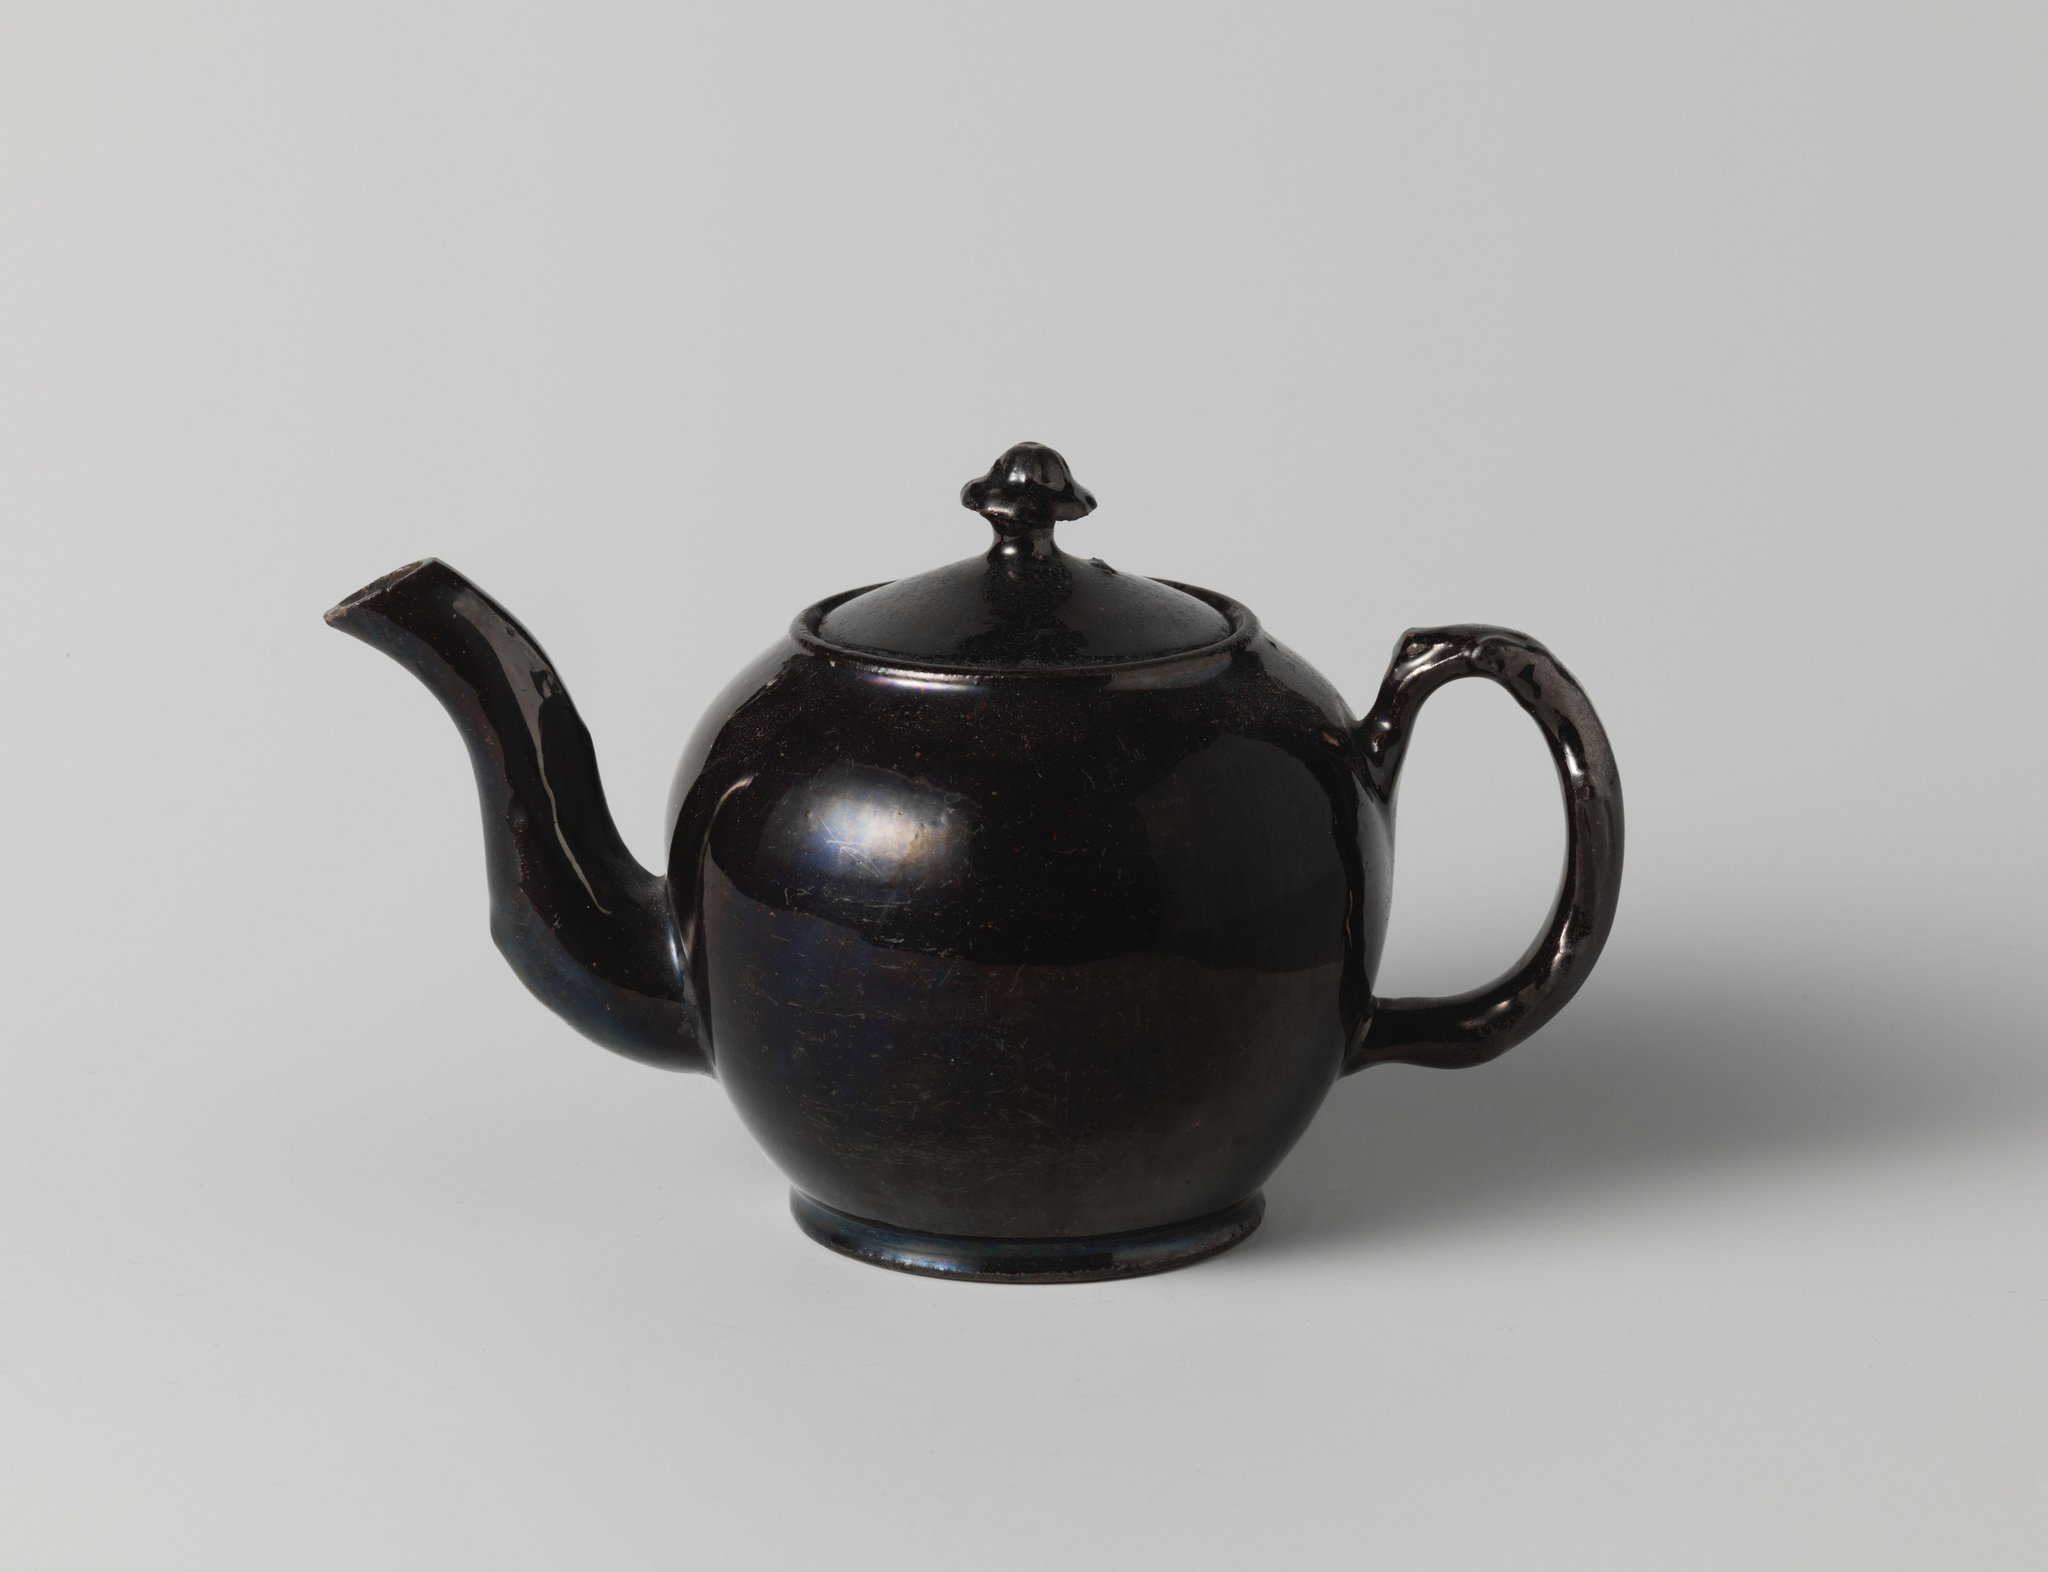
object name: teapot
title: Theepot met deksel van aardewerk met zwartdekkende glazuur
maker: Anonymous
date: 1740-1770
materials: earthenware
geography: jackfield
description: Bolvormige theepot met deksel van aardewerk met zwartdekkende glazuur. De pot heeft een C-vormig oor, een deksel met een knop en een S-vormige tuit.